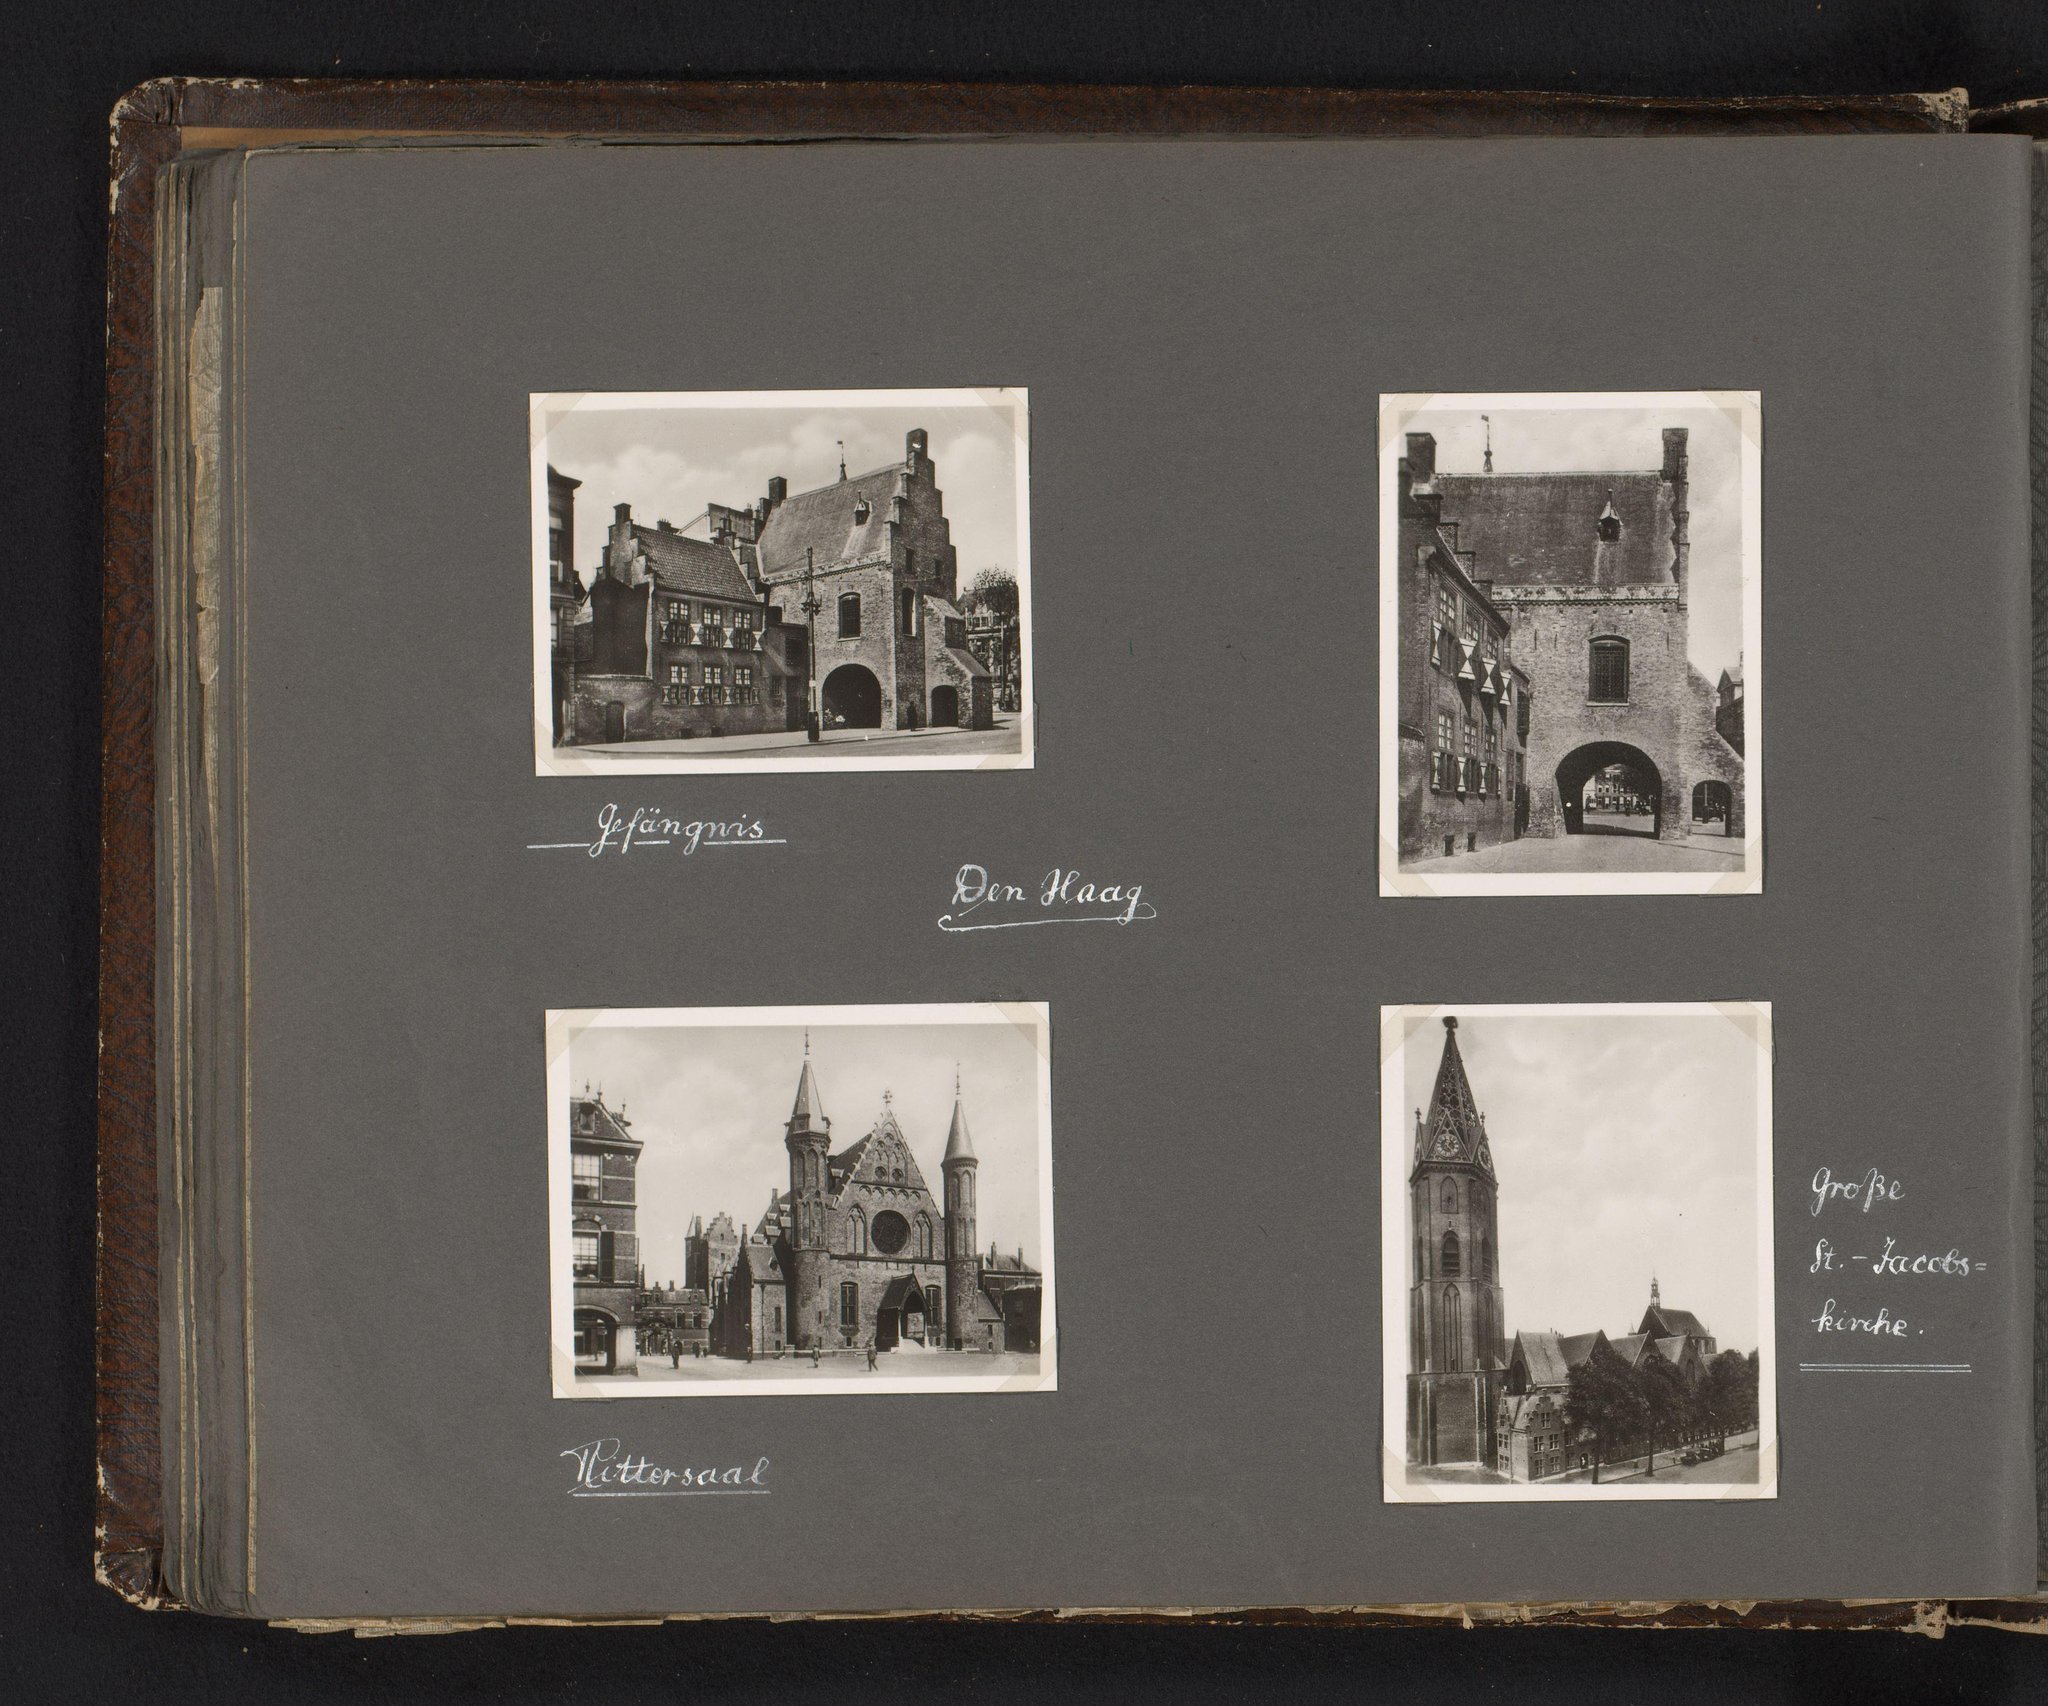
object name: photograph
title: Den Haag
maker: Anonymous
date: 1935-1942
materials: paper, photographic support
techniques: gelatin silver print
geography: the hague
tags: city-view in general; 'veduta', the hague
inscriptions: inscription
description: Albumblad met vier (gekochte) foto's van bezienswaardigheden in Den Haag. Onderdeel van het fotoalbum Kriegsmarine.